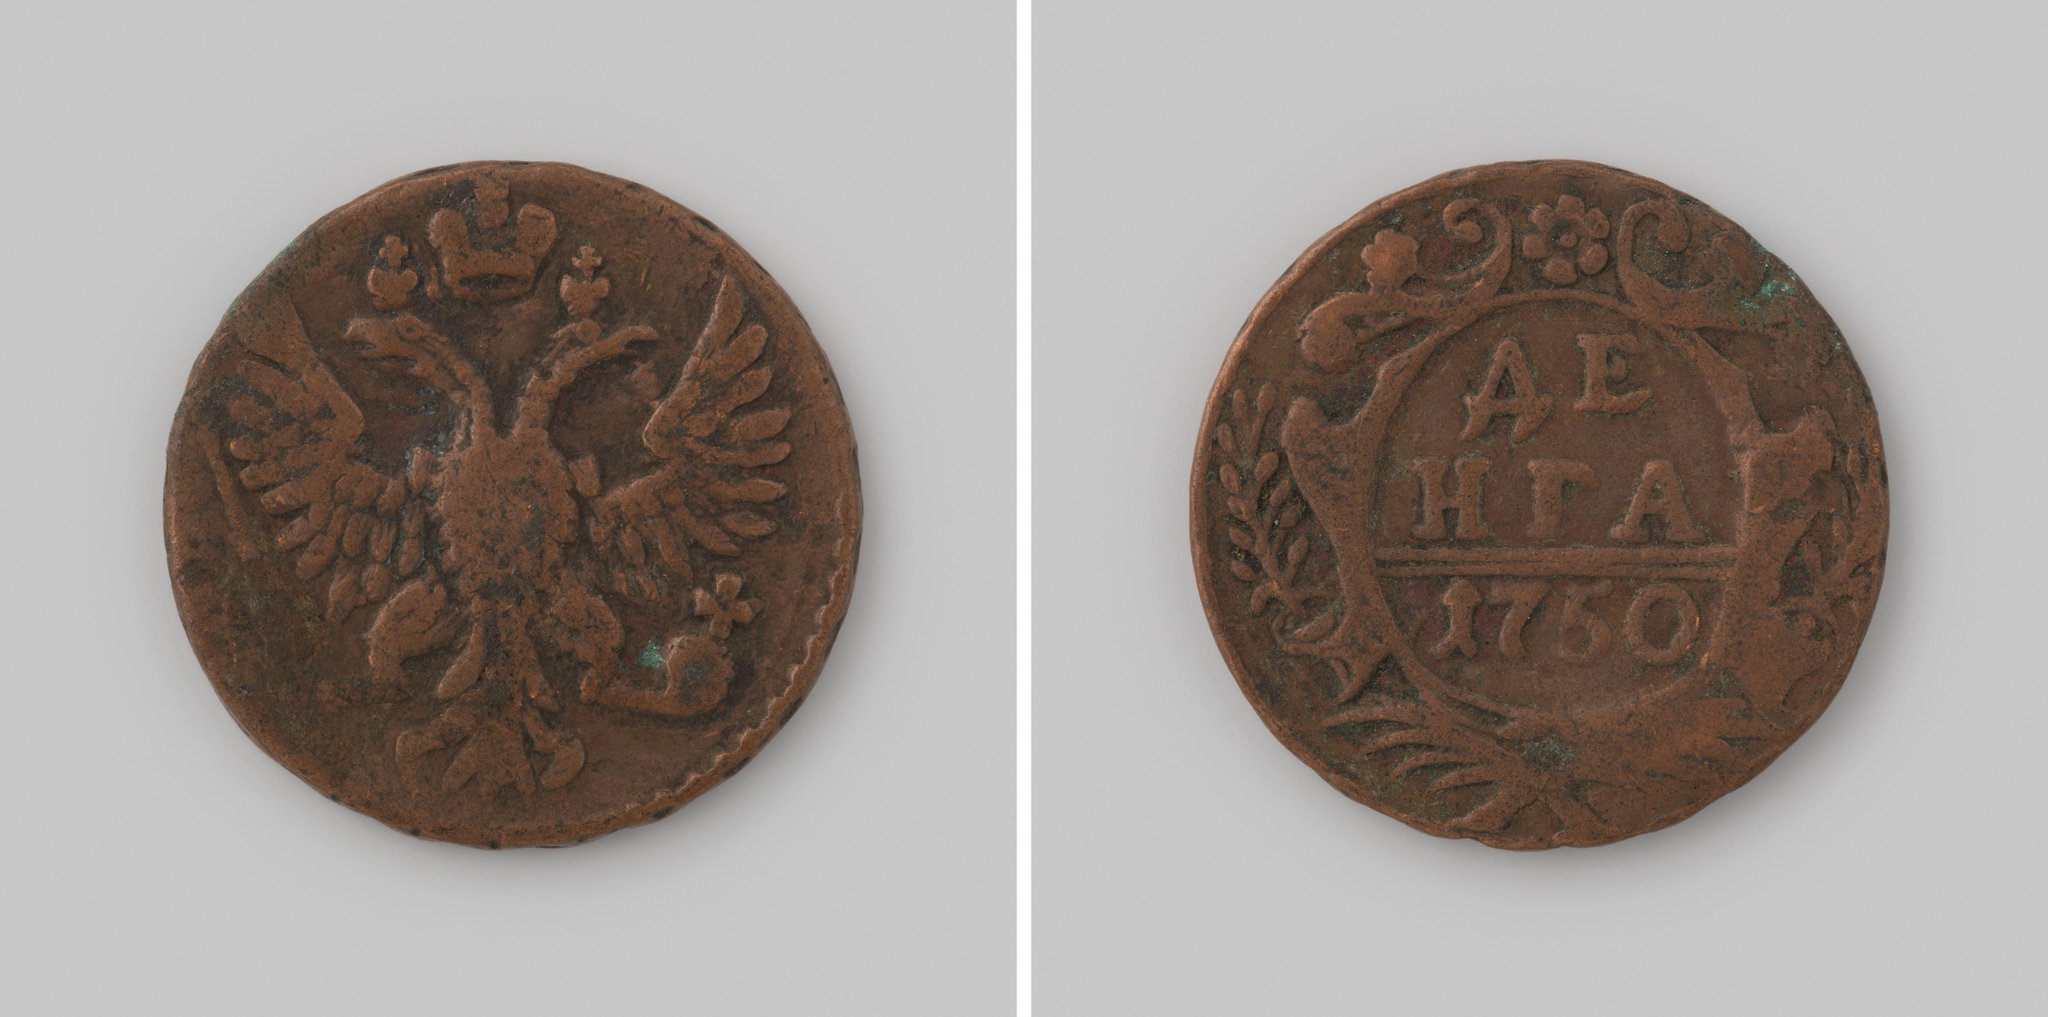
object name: coin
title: Denga uit Rusland van tsarina Elisabet I,1750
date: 1750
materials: copper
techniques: striking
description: Koperen munt. Voorzijde: dubbelkoppige gekroonde adelaar met gespreide vleugels en met in zijn poten scepter en bol met daarop kruis. Boven de adelaar een kroon. Keerzijde: binnen barok-versiering waarde-aanduiding in twee regels, waaronder jaartal. Kabelrand.